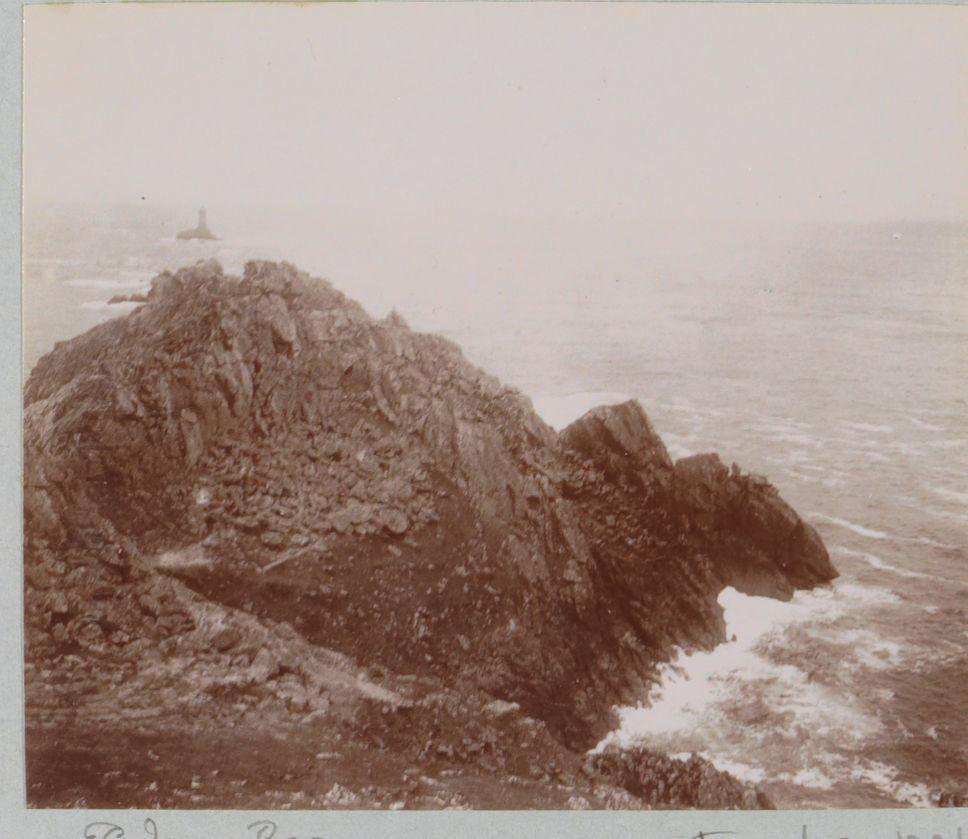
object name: photograph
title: Gezicht op Pointe du Raz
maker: delizy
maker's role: manufacturer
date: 1901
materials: paper, photographic support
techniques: gelatin silver print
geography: pointe du raz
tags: coastal cliff or crag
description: Onderdeel van Fotoalbum van een Franse amateurfotograaf met opnames van uitstapjes in Frankrijk, Spanje, België, Luxemburg en Nederland, de eerste automobielen en autoraces.